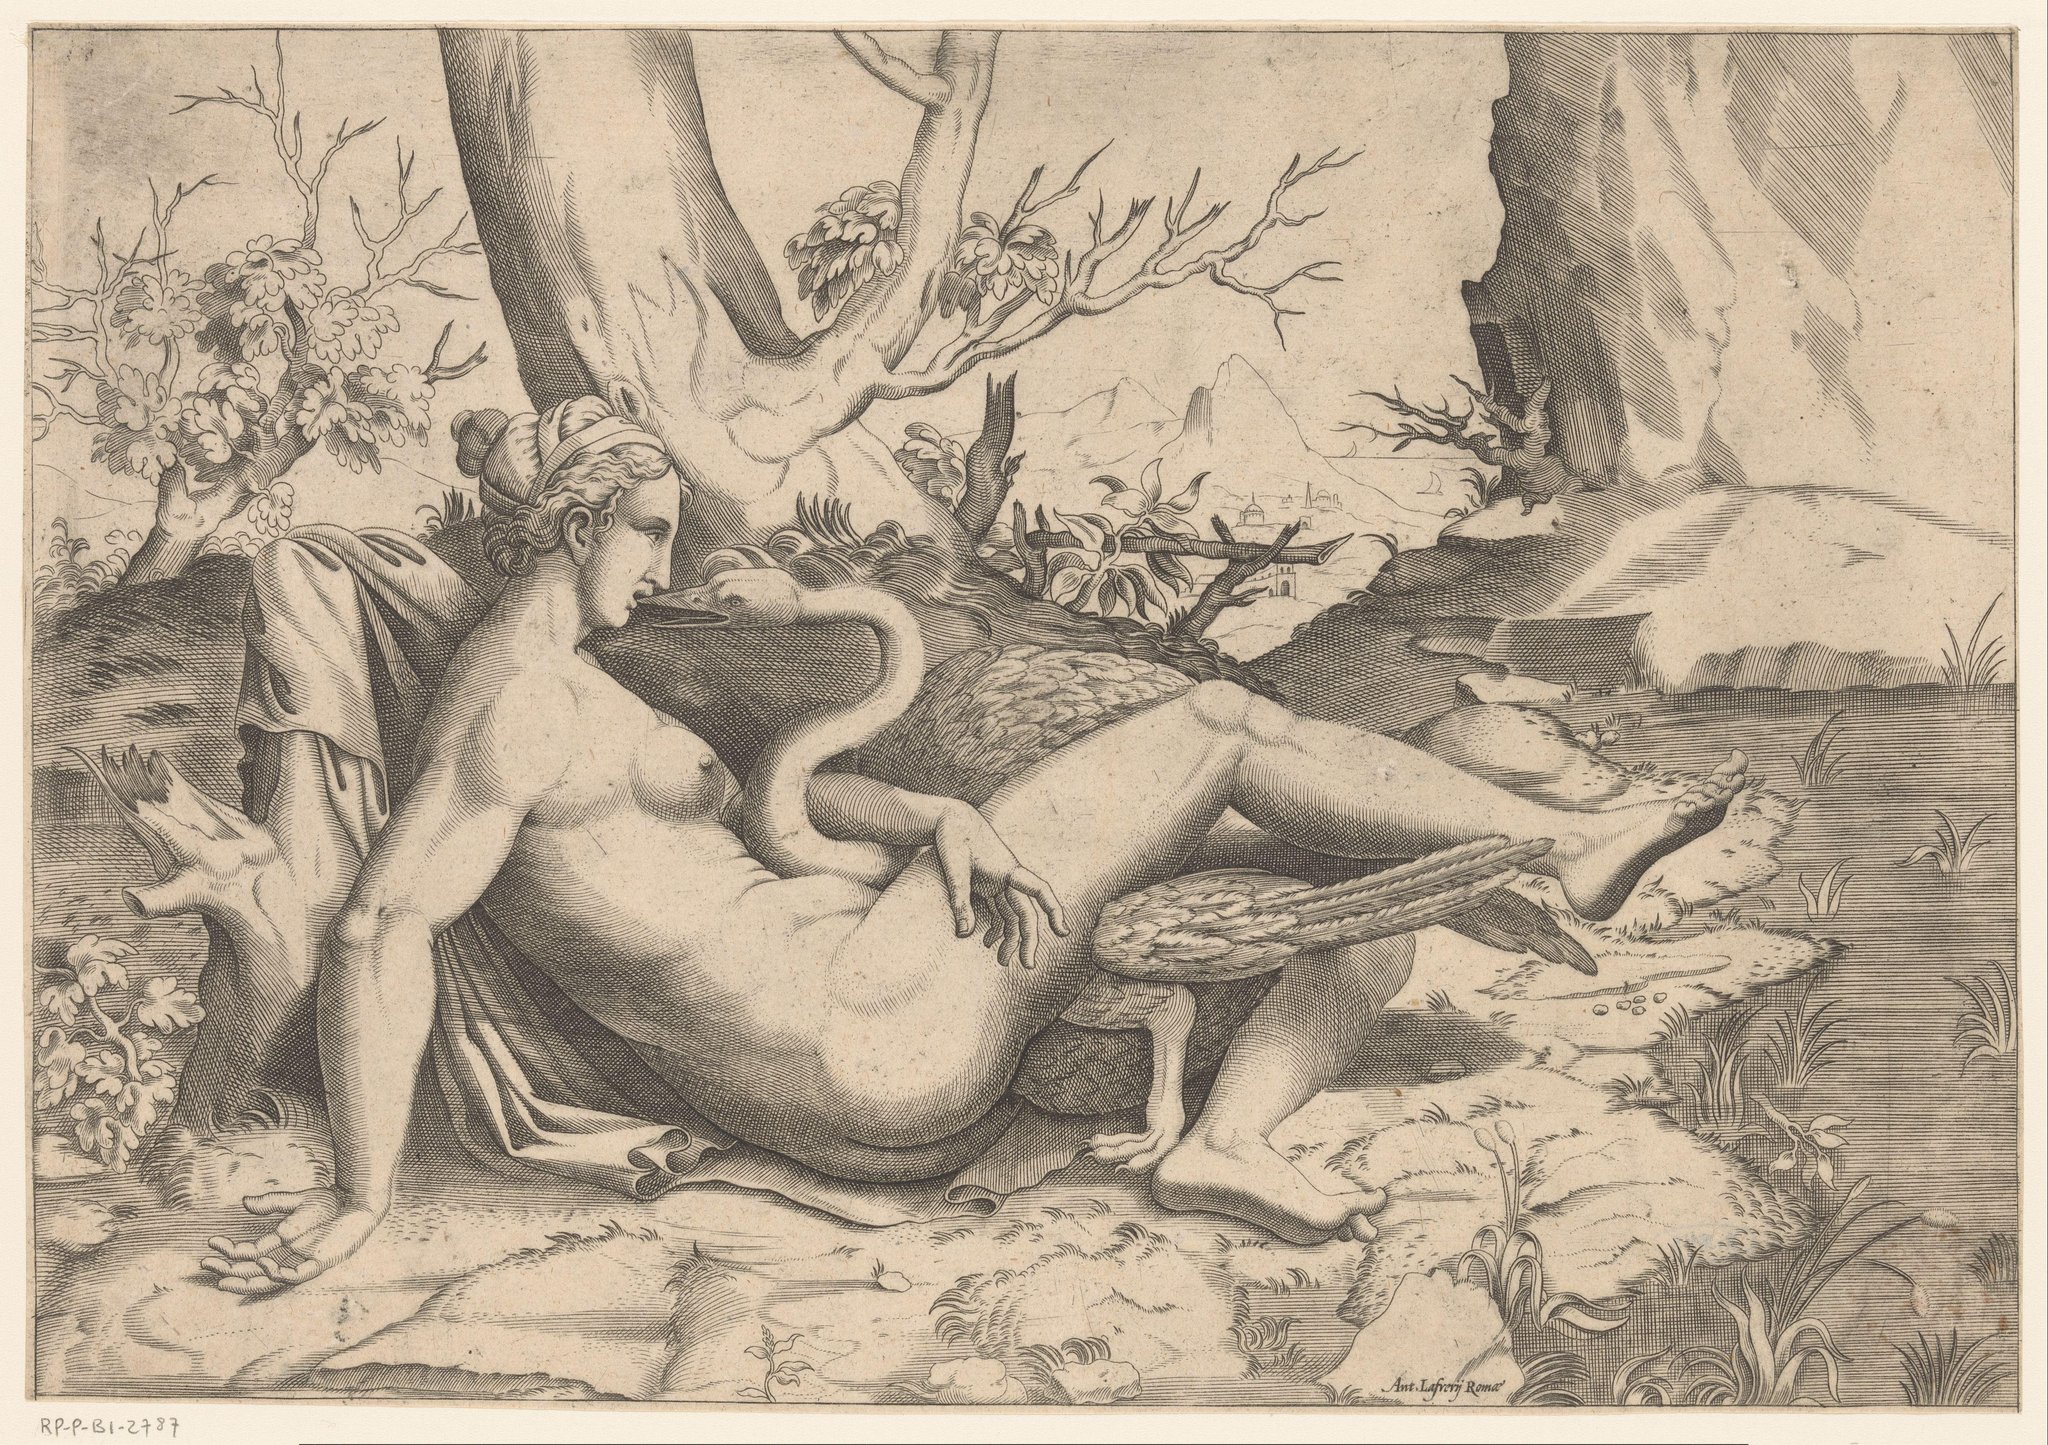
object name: print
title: Leda en de zwaan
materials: paper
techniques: engraving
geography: rome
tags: jupiter, in the shape of a swan, and leda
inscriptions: number: ‘122’, collector's mark: Lugt 2228, collector's mark: Lugt 240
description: De naakte Leda ligt op een doek op de grond. Tussen haar benen Jupiter in de gedaante van een zwaan. Rechts een rivier.